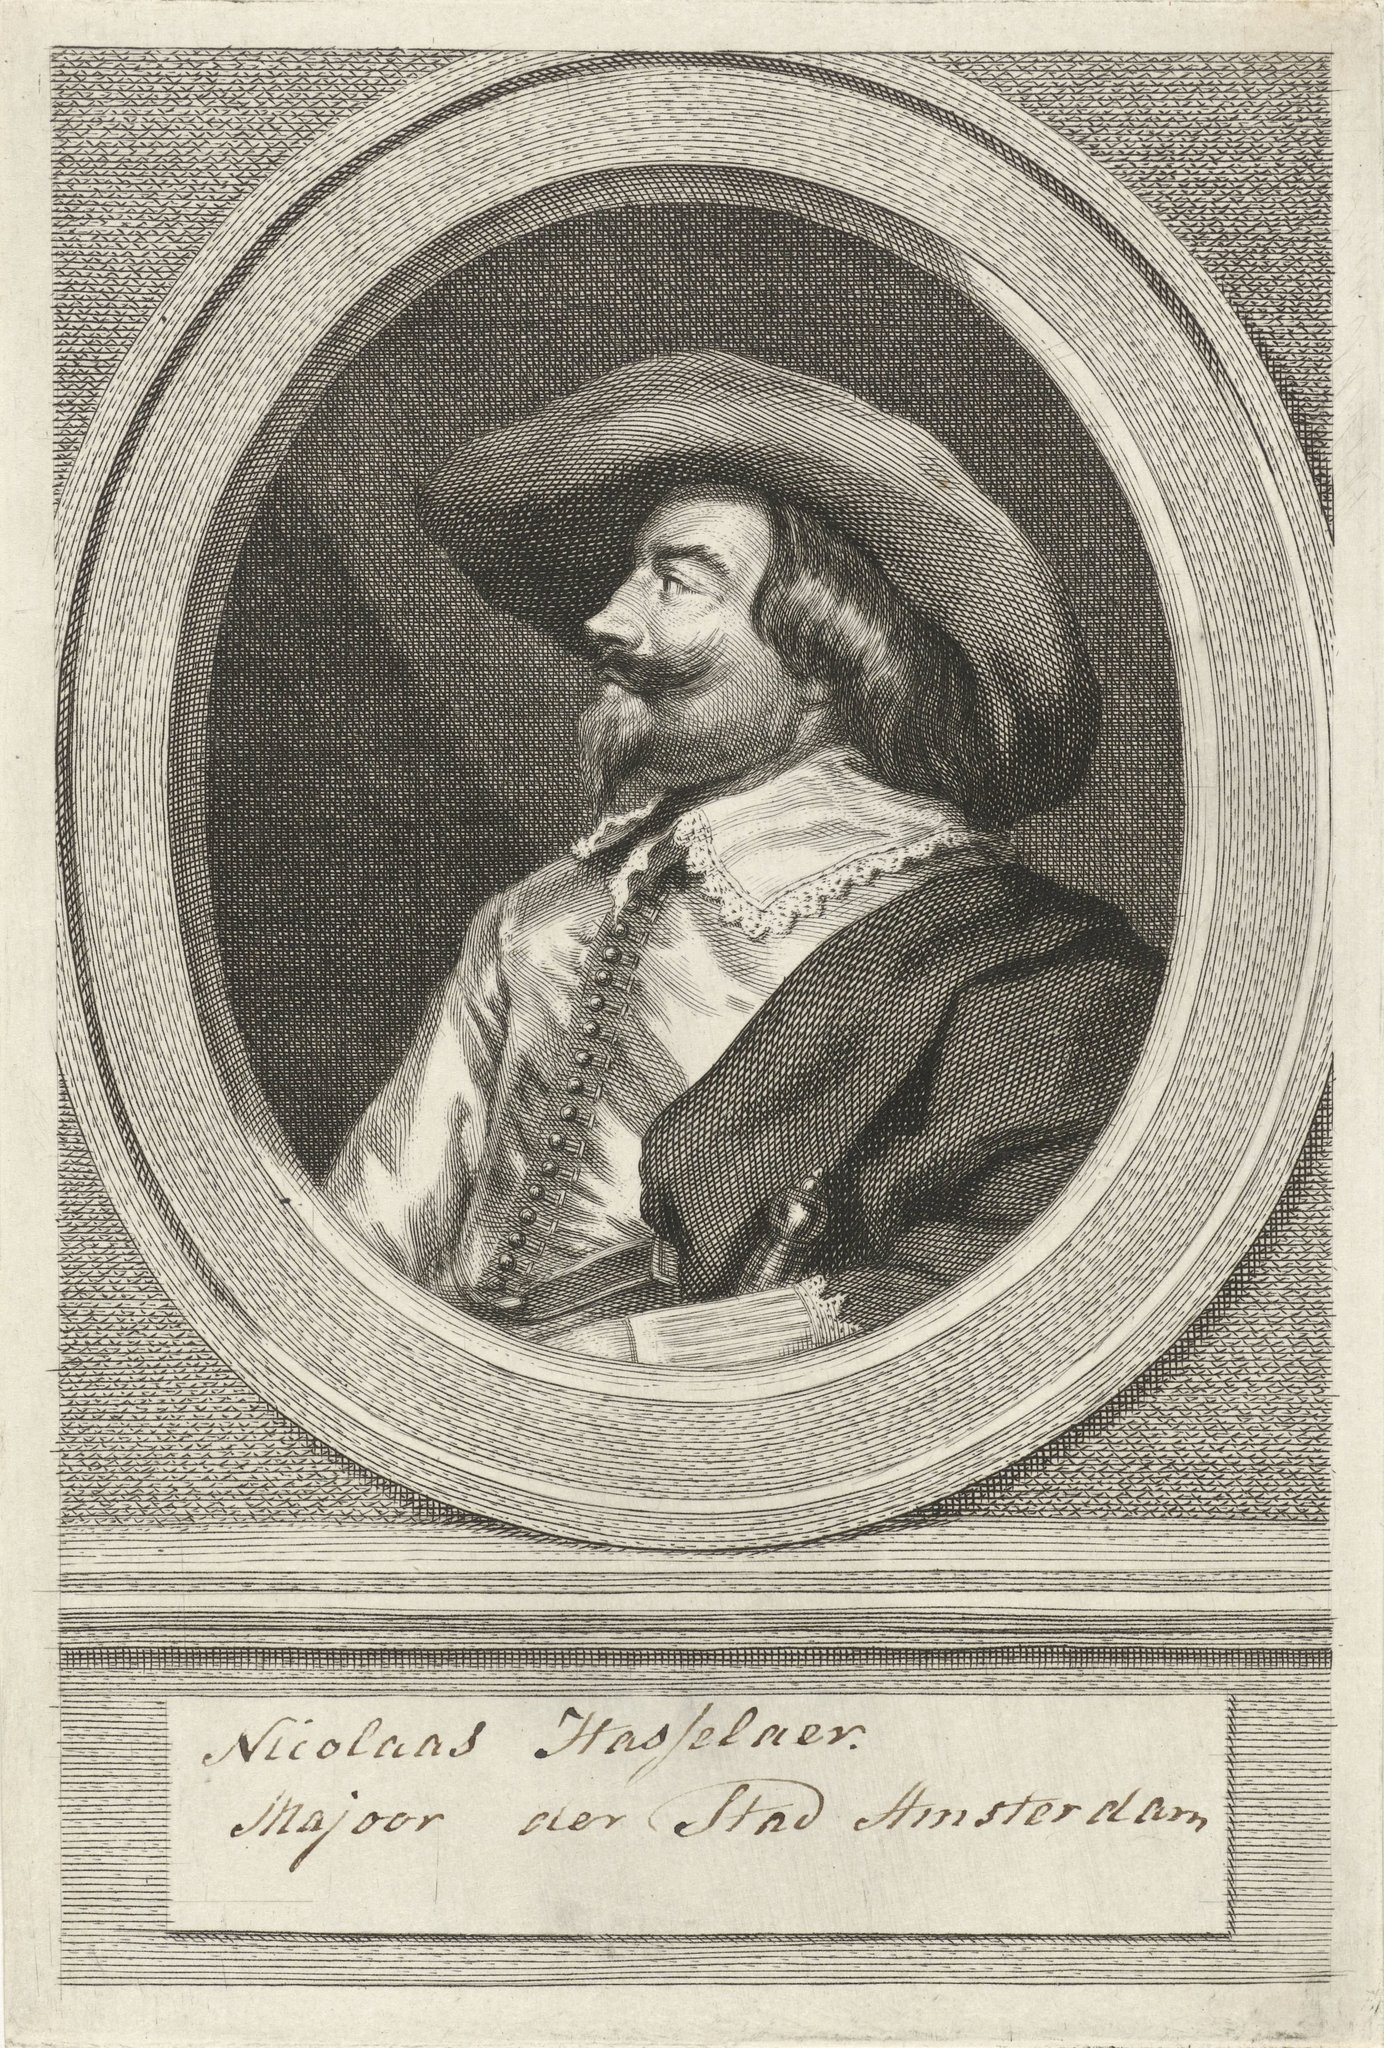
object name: print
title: Portret van Nikolaas Hasselaer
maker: jacob houbraken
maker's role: draughtsman, print maker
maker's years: 1698-1780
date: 1749-1780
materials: ink, paper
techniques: engraving, pen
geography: amsterdam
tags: historical persons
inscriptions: collector's mark: Lugt 2228, inscription: ‘Nicolaas Hasselaer./ Majoor der Stad Amsterdam’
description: Latere staat van deze prent is oorspronkelijk bedoeld als aanvulling op Jan Wagenaars ‘Vaderlandsche historie’* en was zo vanaf 1796 verkrijgbaar bij Johannes Allart te Amsterdam. Voor de advertentie waarin Allart de 60 portretten en 7 platen, allen gegraveerd door Houbraken, ter aanvulling op Wagenaars ‘Vaderlandsche historie’ aanbiedt, zie RP-P-OB-77.766. *Van dit werk zijn in de achttiende eeuw meerdere uitgaves verschenen, zoals: Wagenaar, Jan. Vaderlandsche historie, vervattende de geschiedenissen der Vereenigde Nederlanden (…). 21 delen. Amsterdam: Isaak Tirion, 1749-1759. Wagenaar, Jan. Vaderlandsche historie, vervattende de geschiedenissen der nu Vereenigde Nederlanden (…). 21 delen. Amsterdam: weduwe Isaak Tirion, 1770. Wagenaar, Jan. Vaderlandsche historie, vervattende de geschiedenissen der nu Vereenigde Nederlanden (…). 21 delen. Amsterdam, Leiden, Dordrecht en Harlingen: P. Schouten e.a., 1782. Wagenaar, Jan. Vaderlandsche historie, vervattende de geschiedenissen der nu Vereenigde Nederlanden (…). 21 delen. Amsterdam: Johannes Allart, 1790-1796.